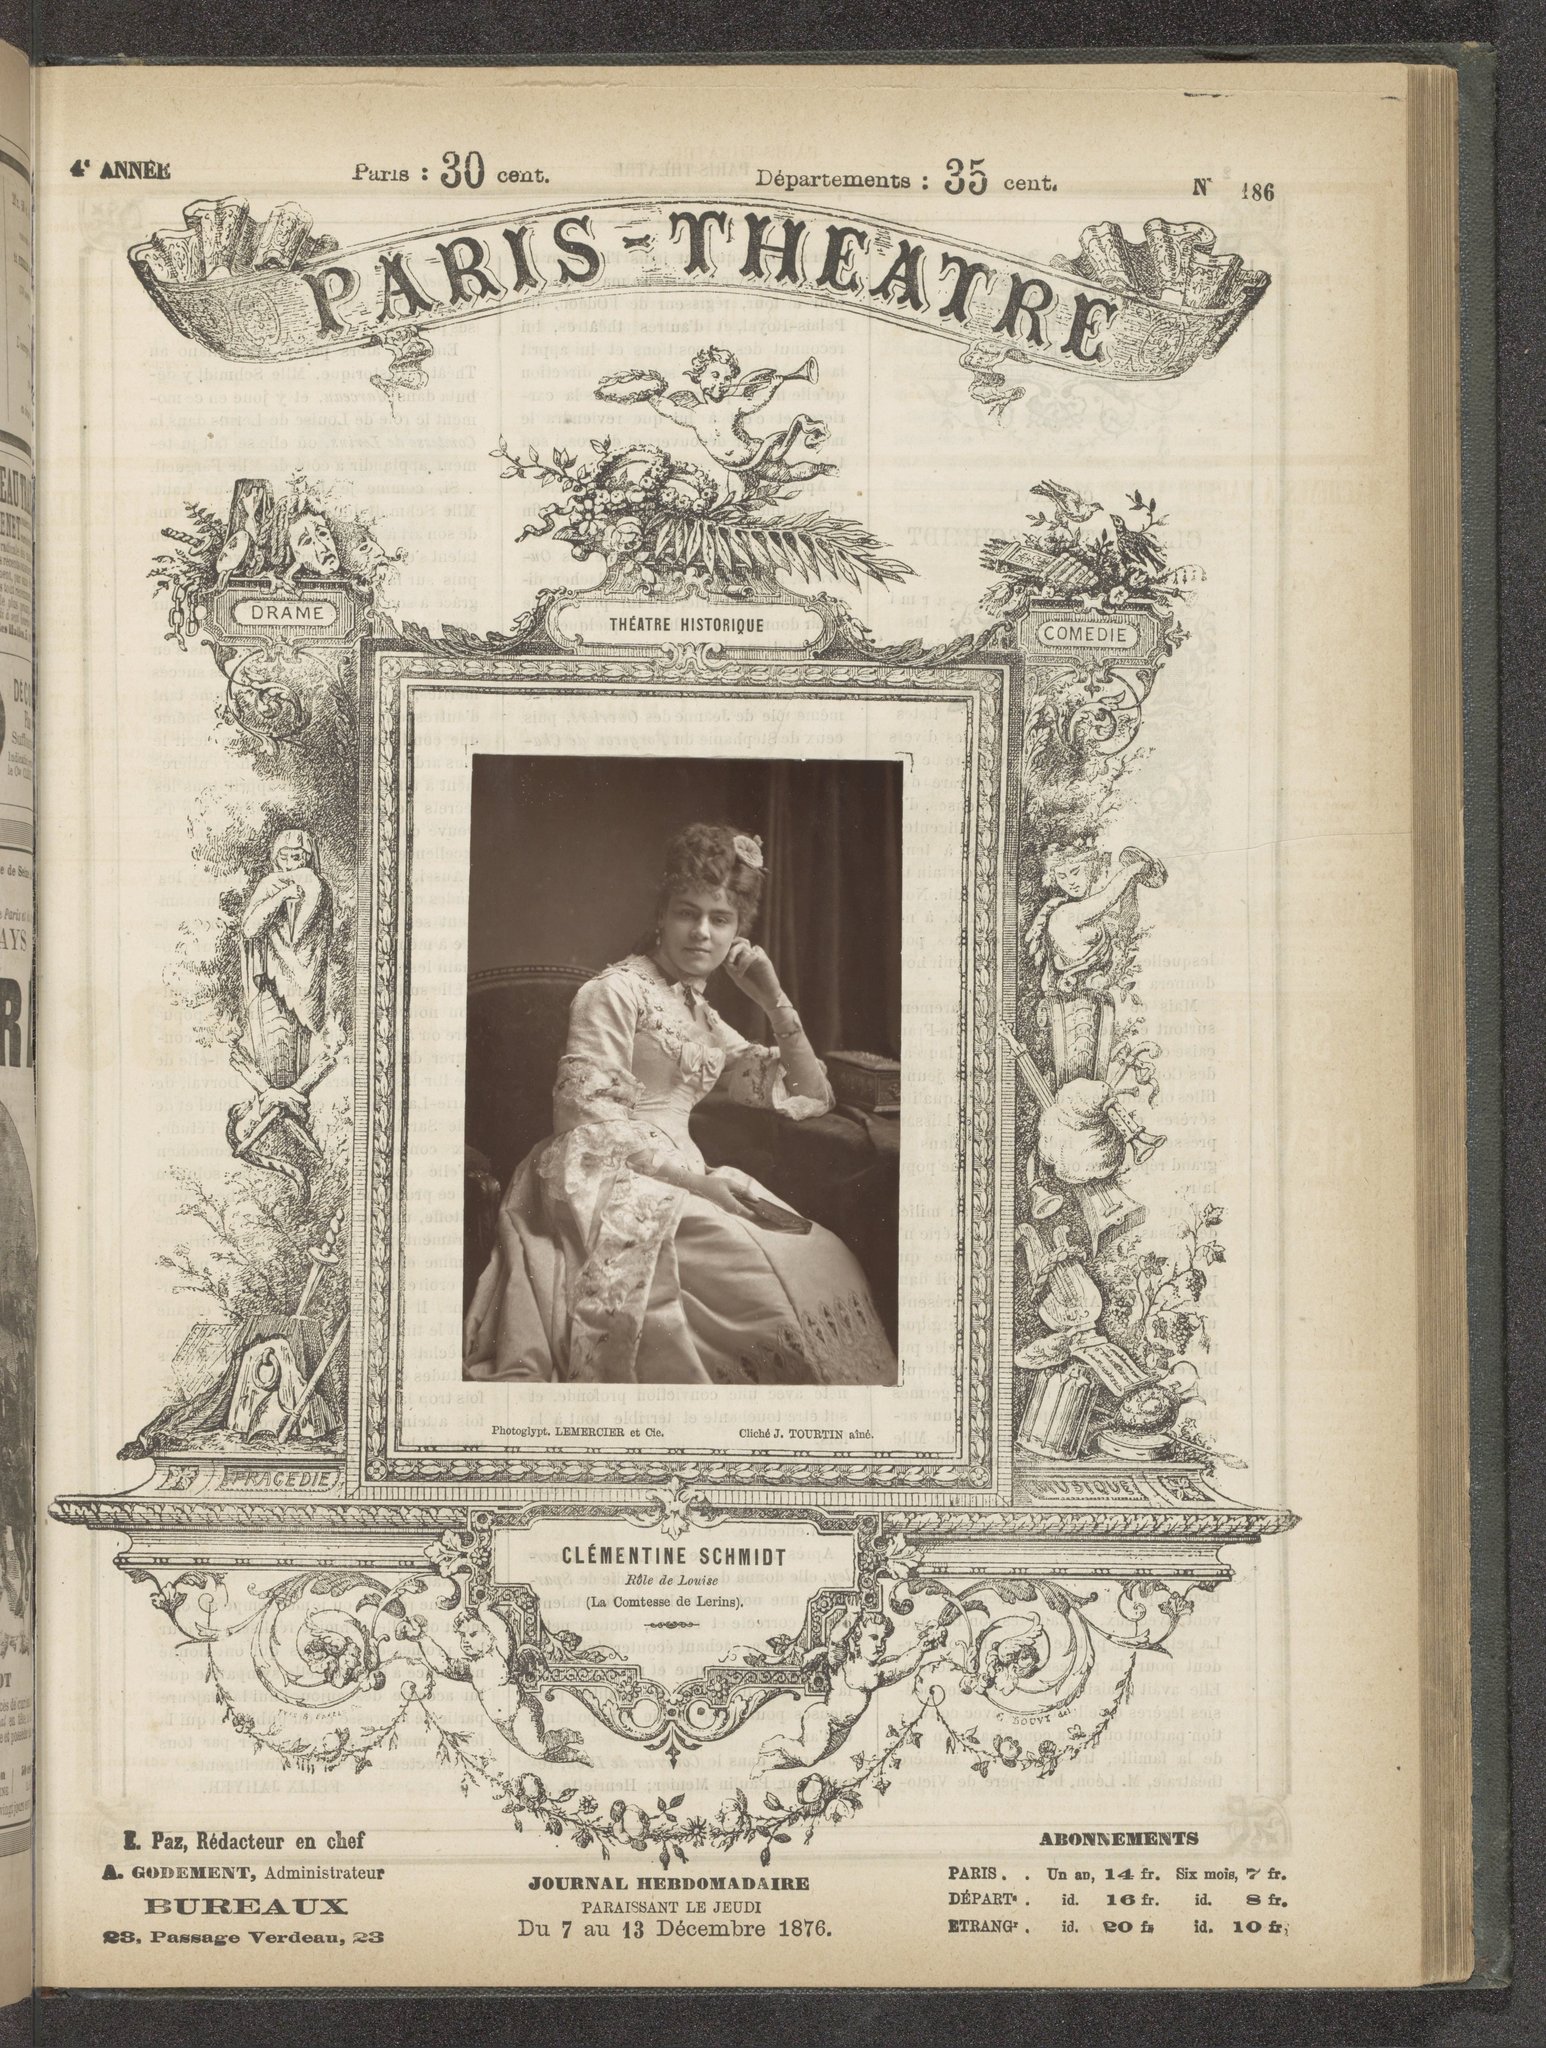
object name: page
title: Clémentine Schmidt rôle de Louise (La Comtesse de Lerins)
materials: paper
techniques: woodburytype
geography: france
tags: portrait of actor, actress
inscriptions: inscription: ‘Journal hebdomadaire paraissant le jeudi Du 7 au 13 Décembre 1876’, number: ‘N' 186’